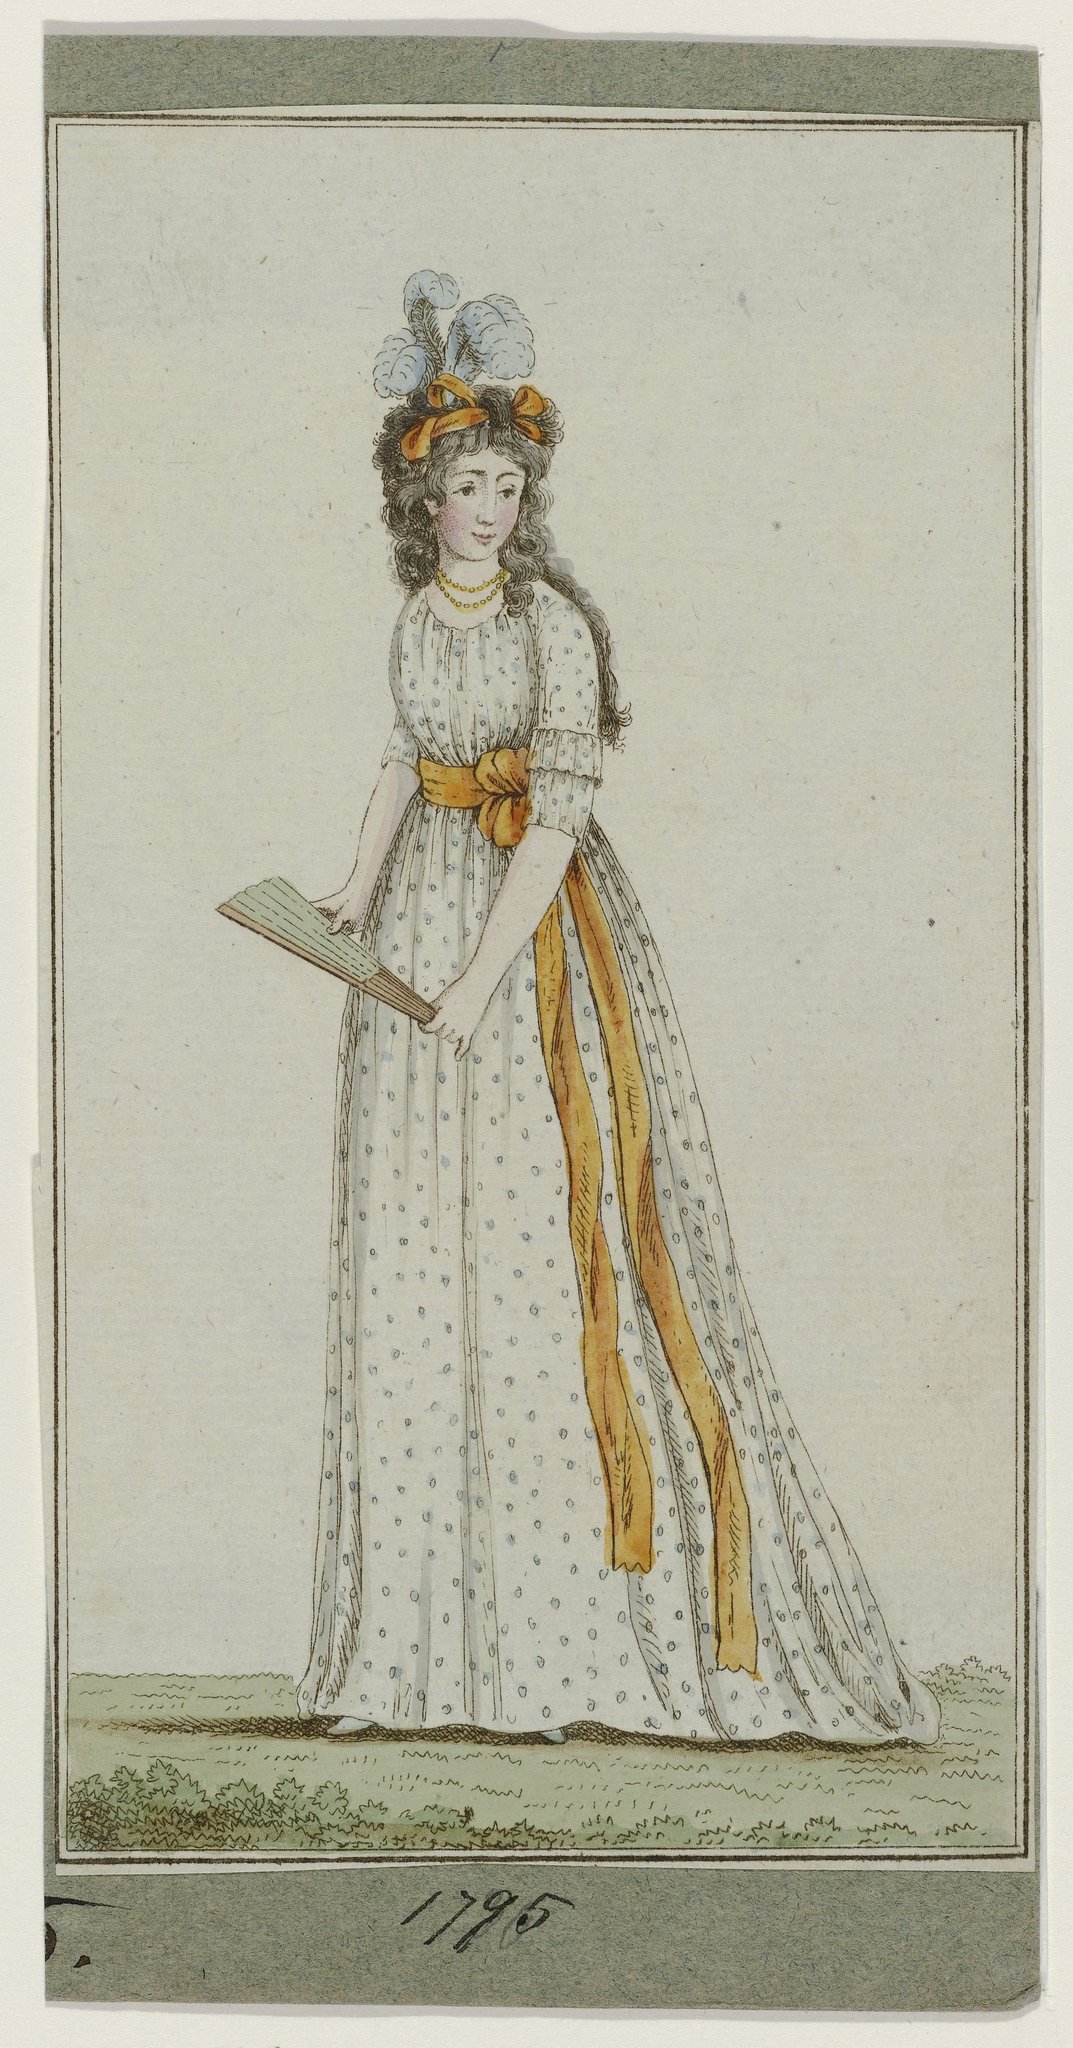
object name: fashion print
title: Journal des Luxus und der Moden, 1795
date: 1795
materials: paper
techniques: etching, hand coloring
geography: weimar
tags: fashion plates, shoes, sandals (+ women's clothes), dress, gown (+ women's clothes), necklace (+ women's clothes), belt, girdle, waistband (+ women's clothes)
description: Vrouw in een gestippelde japon met driekwart mouwen en sleepje. Het lange gekrulde haar is versierd met een lint en struisveren. Accessoires: collier bestaande uit twee snoeren, om het middel een breed lint (ceintuur) gestrikt, vouwwaaier. Prent uit het modetijdschrift Journal des Luxus und der Moden, uitgegeven door Friedrich Justin Bertuch en Georg Melchior Kraus, Weimar, 1786-1826.